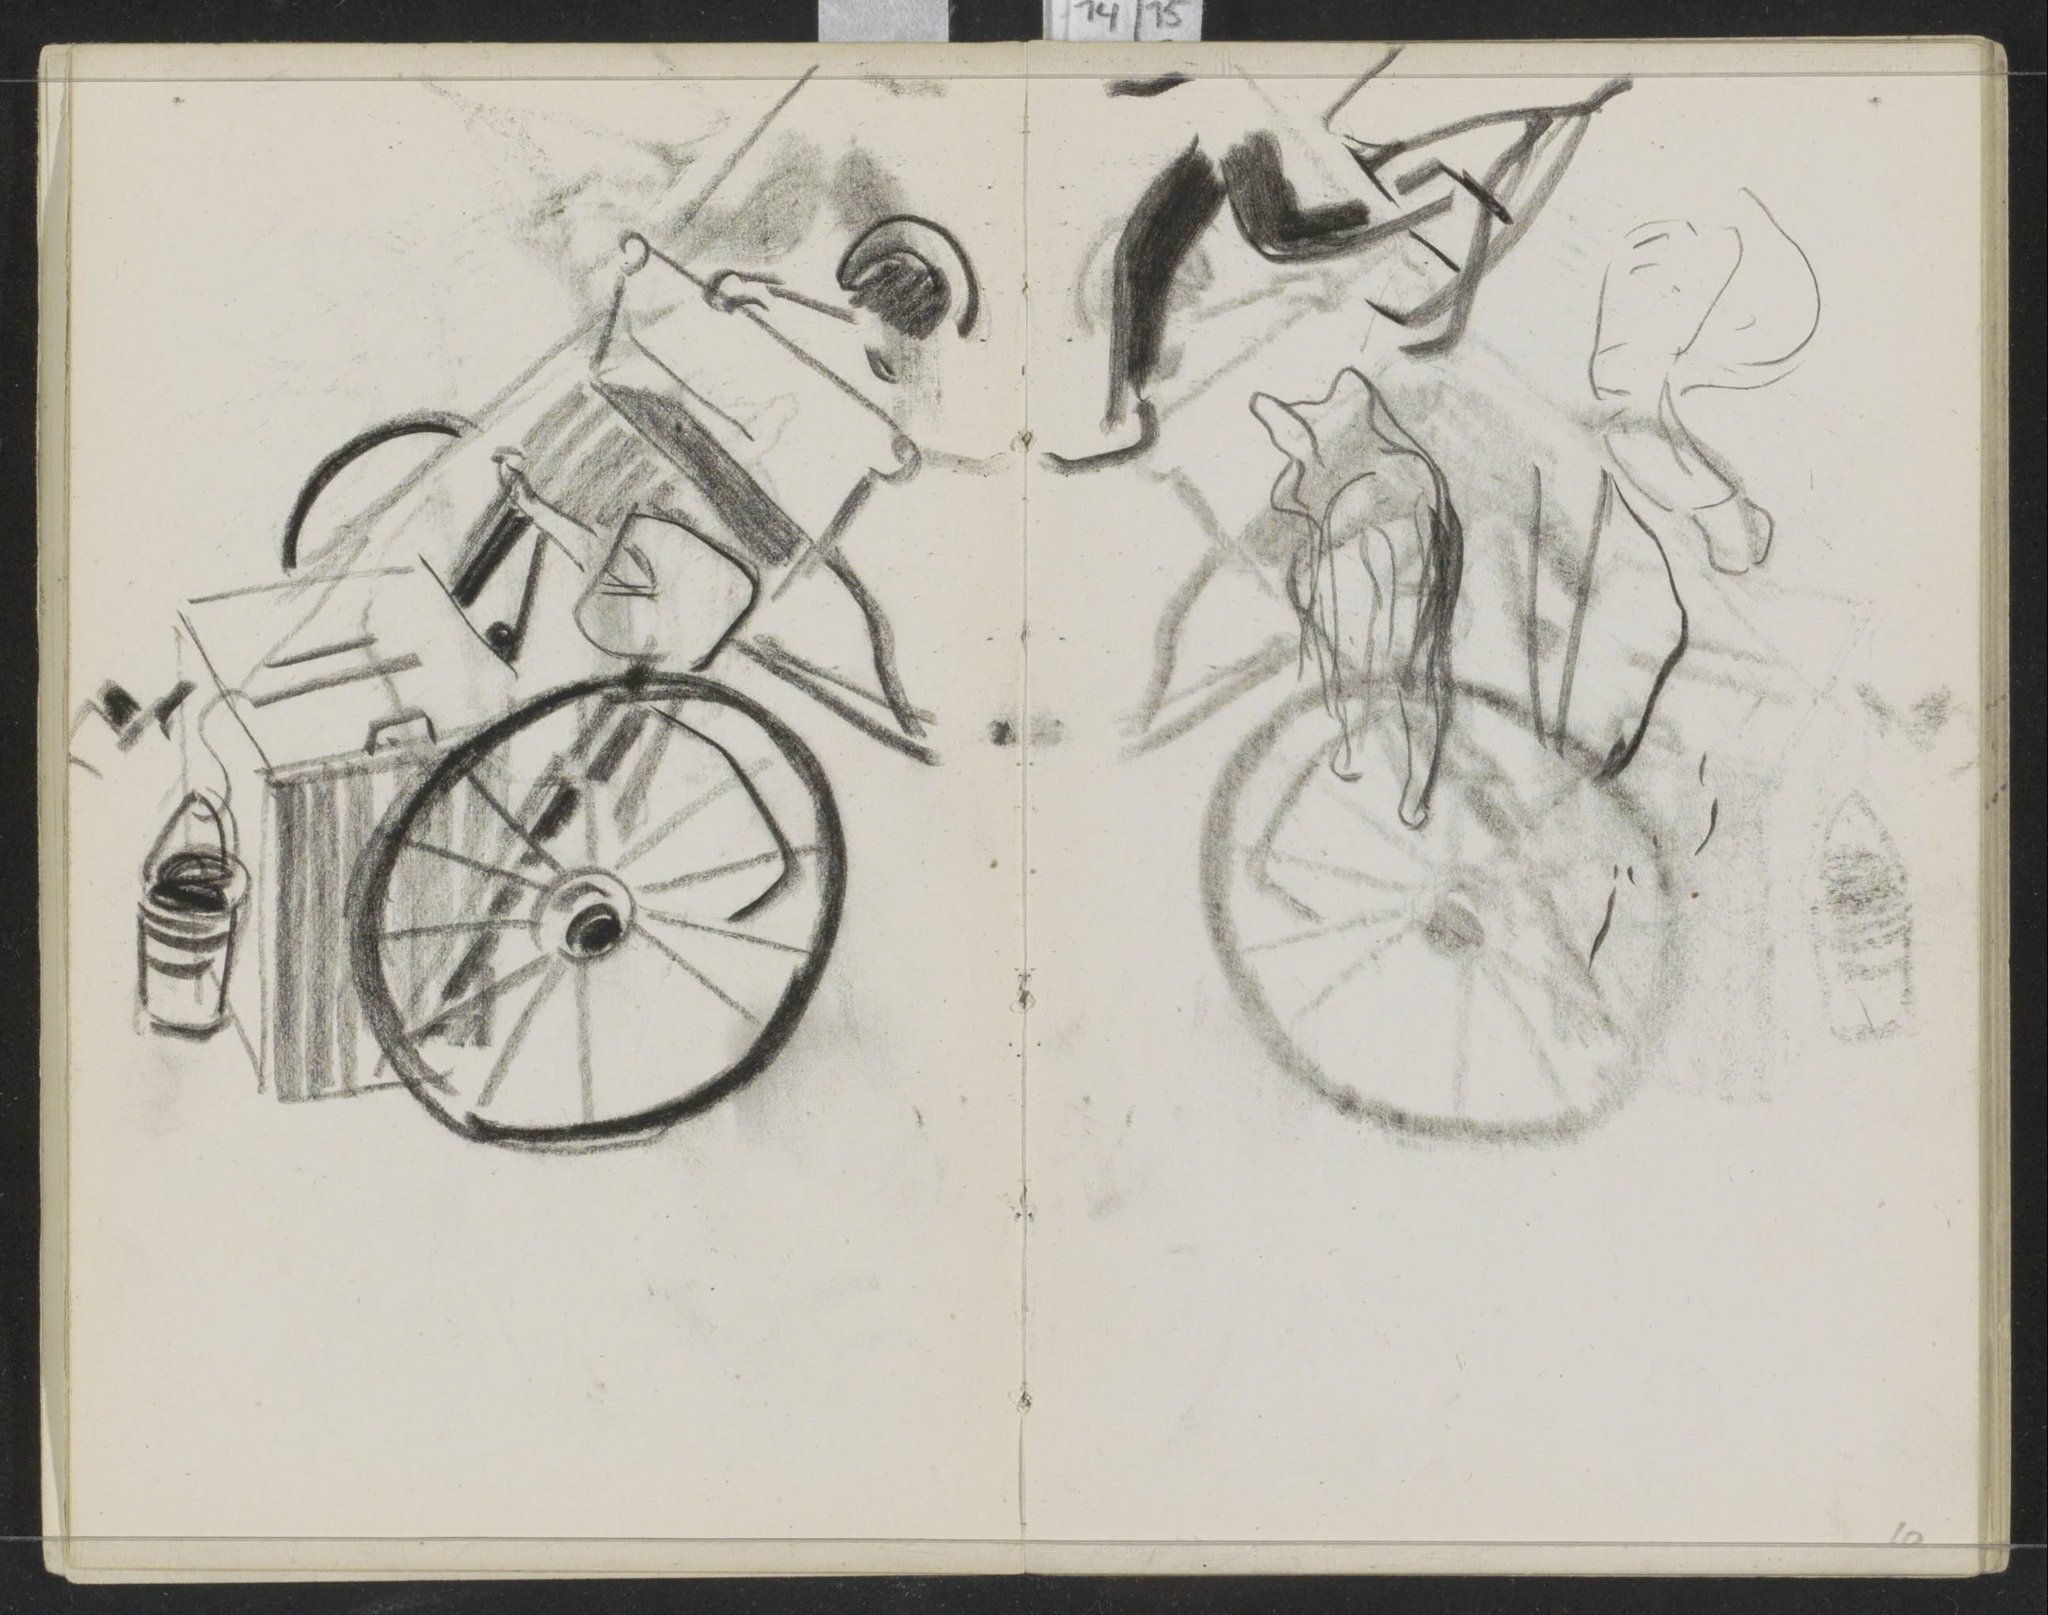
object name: sketchbook leaf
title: Kar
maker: carel adolph lion cachet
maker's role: draughtsman, print maker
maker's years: 1864-1945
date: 1874-1945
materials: chalk, paper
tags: hand-cart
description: Aan de kar hangt een emmer. Tevens enkele studies. Blad 9 verso en 10 recto uit een schetsboek met 41 bladen.